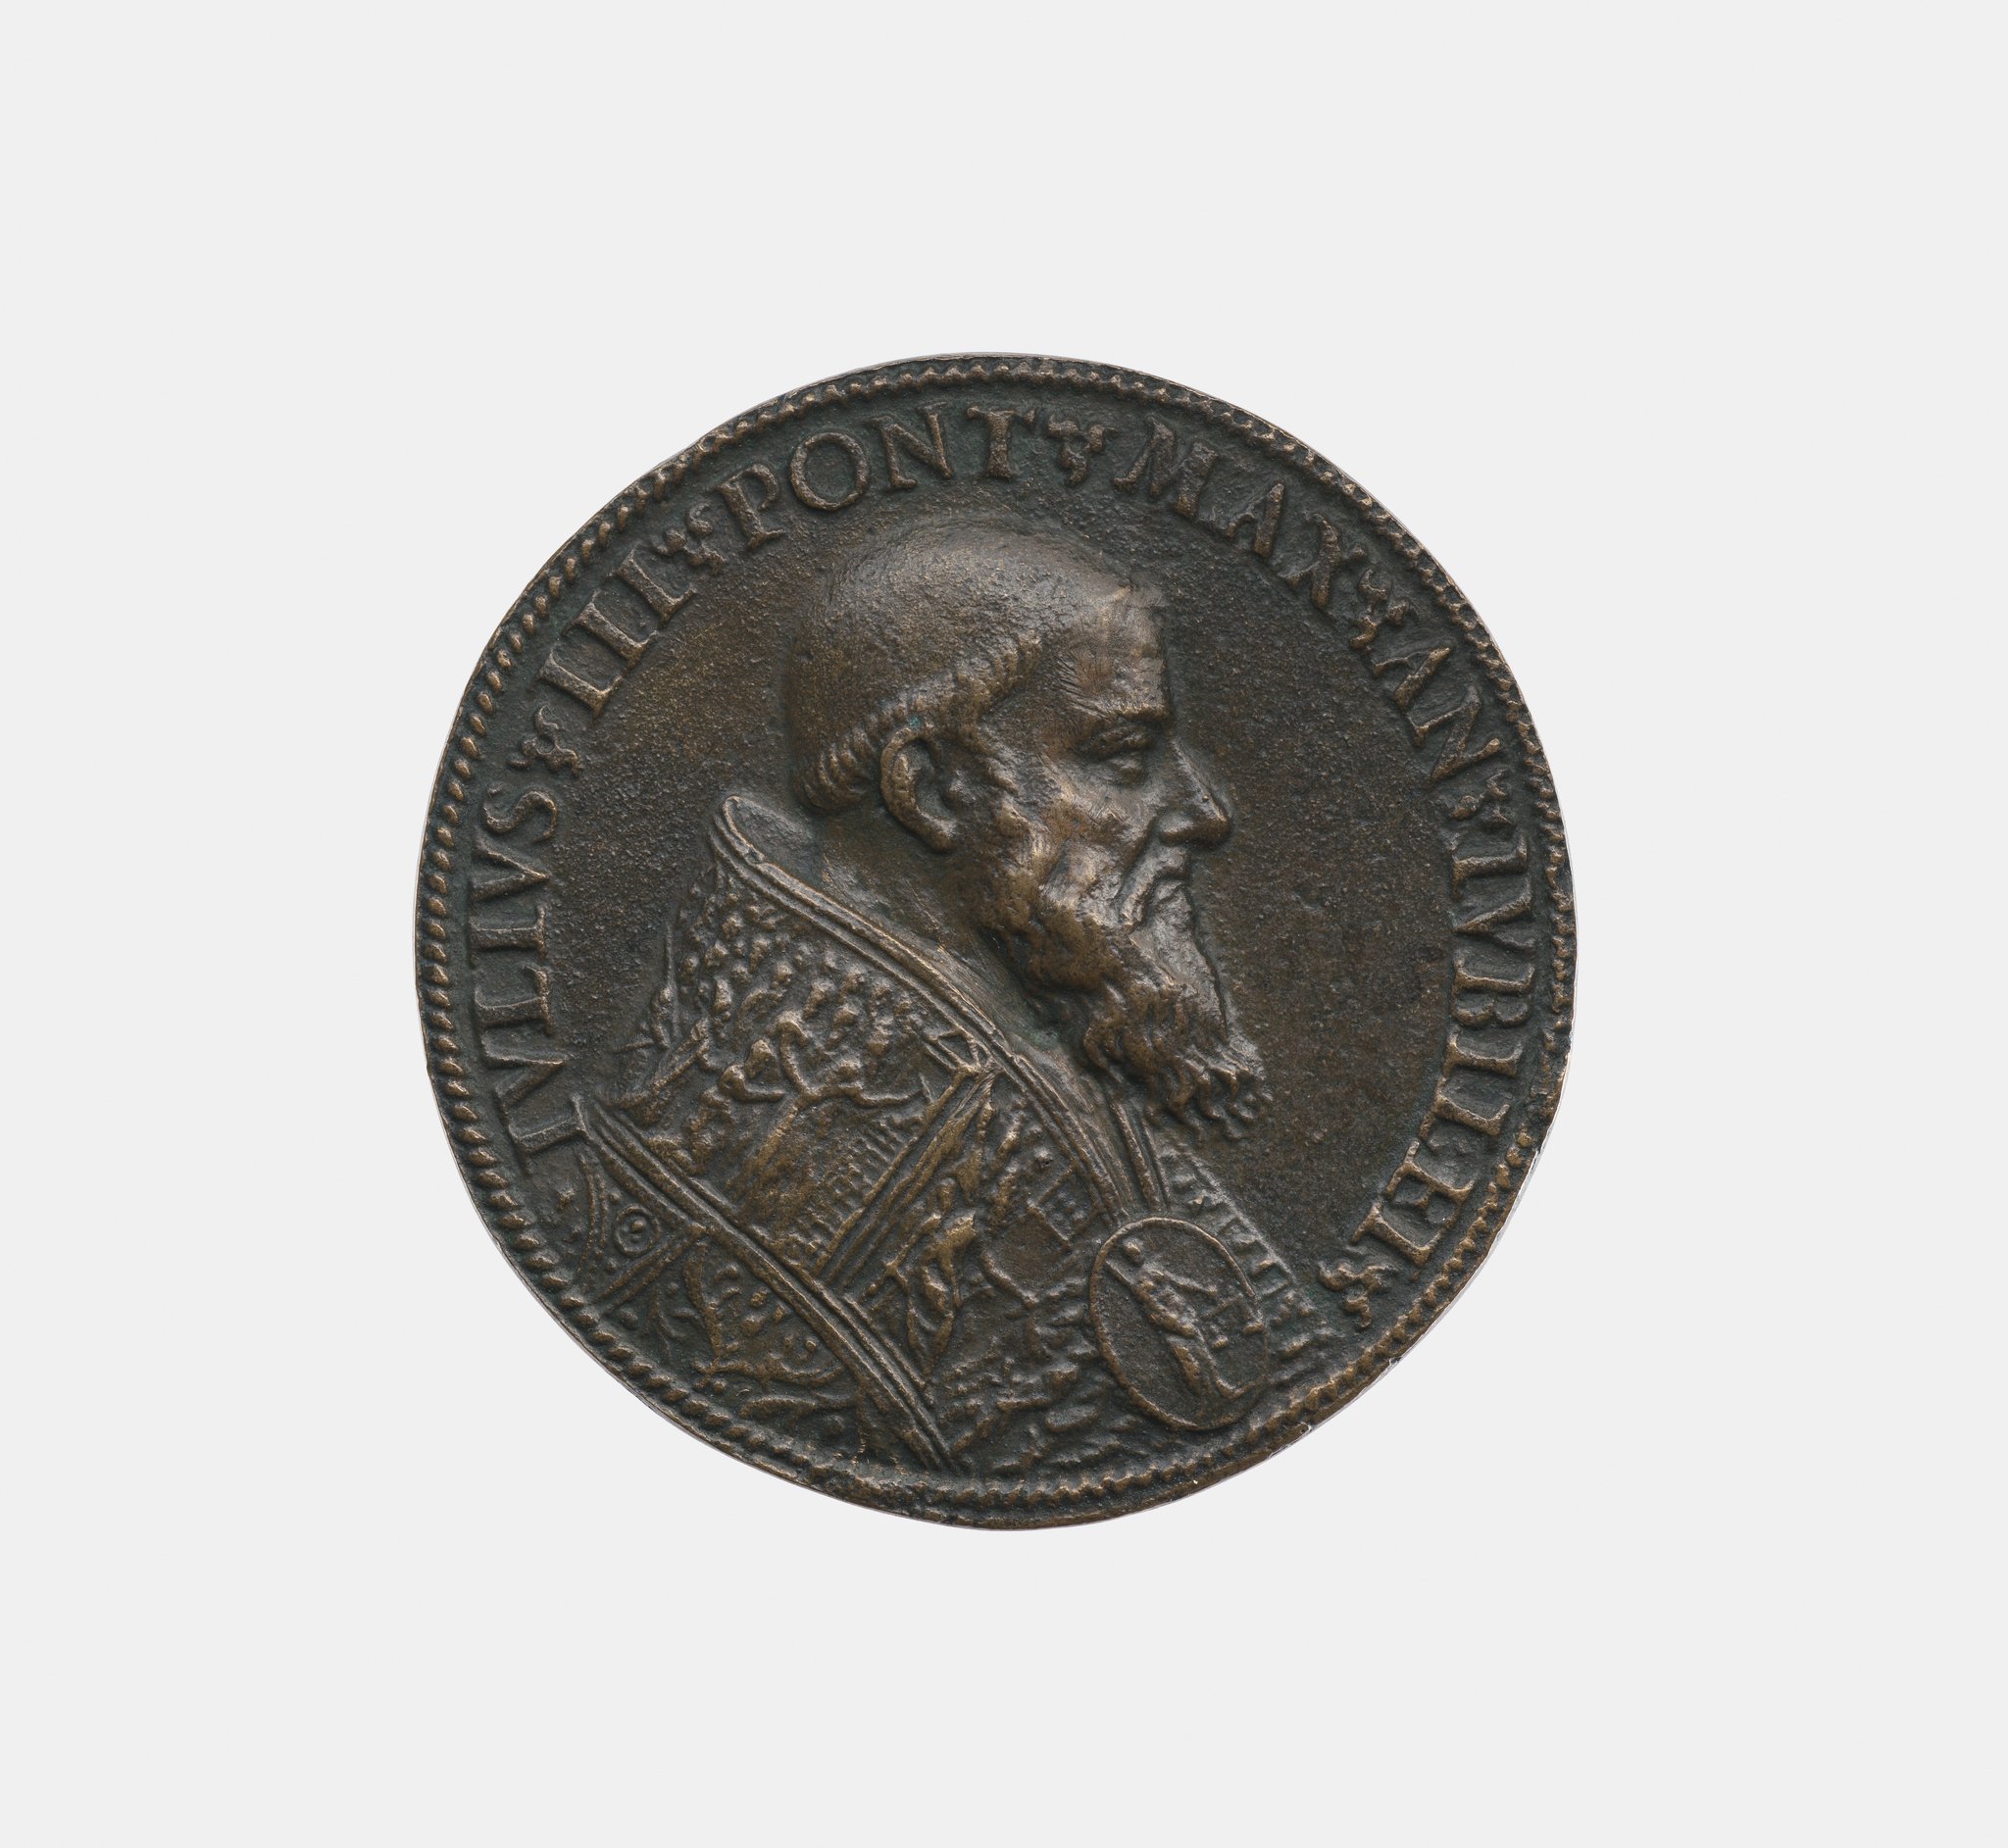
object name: medal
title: Pope Julius III (r. 1550–55)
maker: gian federigo bonzagna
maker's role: artist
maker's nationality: italian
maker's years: 1507-1588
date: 1550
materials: bronze